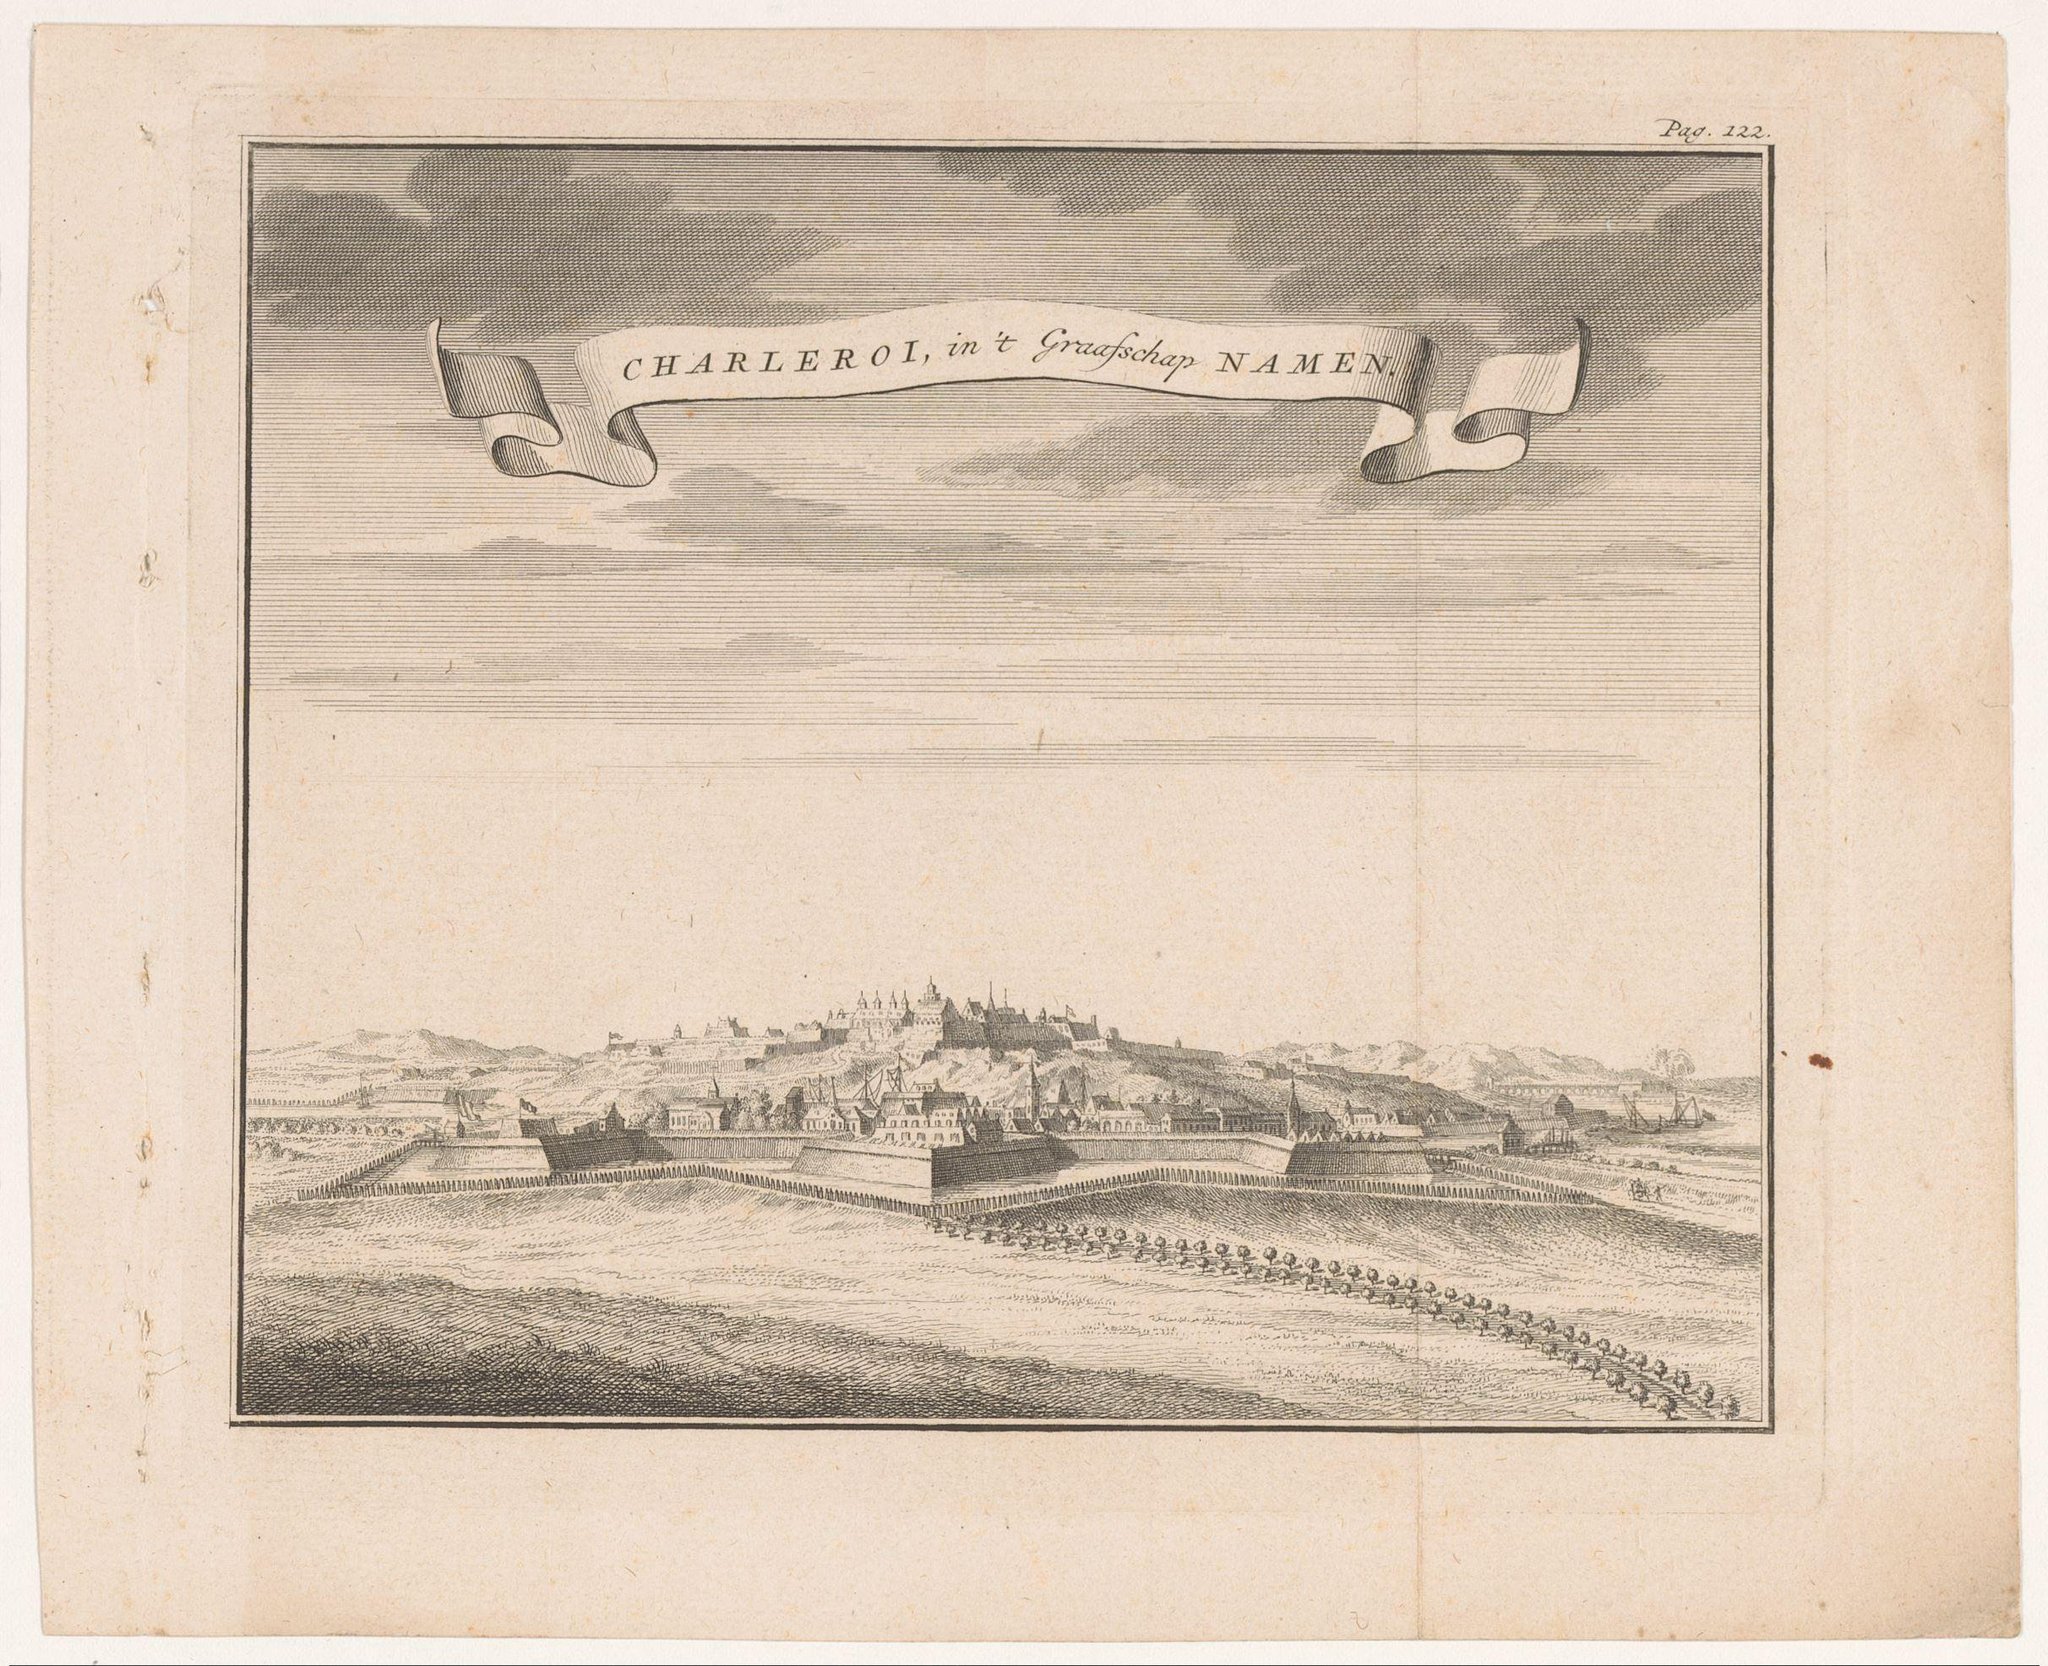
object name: book illustration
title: Charleroi in 't graafschap Namen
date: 1742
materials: paper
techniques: engraving, etching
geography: amsterdam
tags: city-view in general; 'veduta', fortified city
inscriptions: collector's mark: Lugt 2233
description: Prent uit: Wagenaar, Jan. Hedendaagsche historie, of tegenwoordige staat der Oostenryksche, Fransche en Pruissische Nederlanden. Amsterdam: Isaak Tirion, 1742, p. 122.